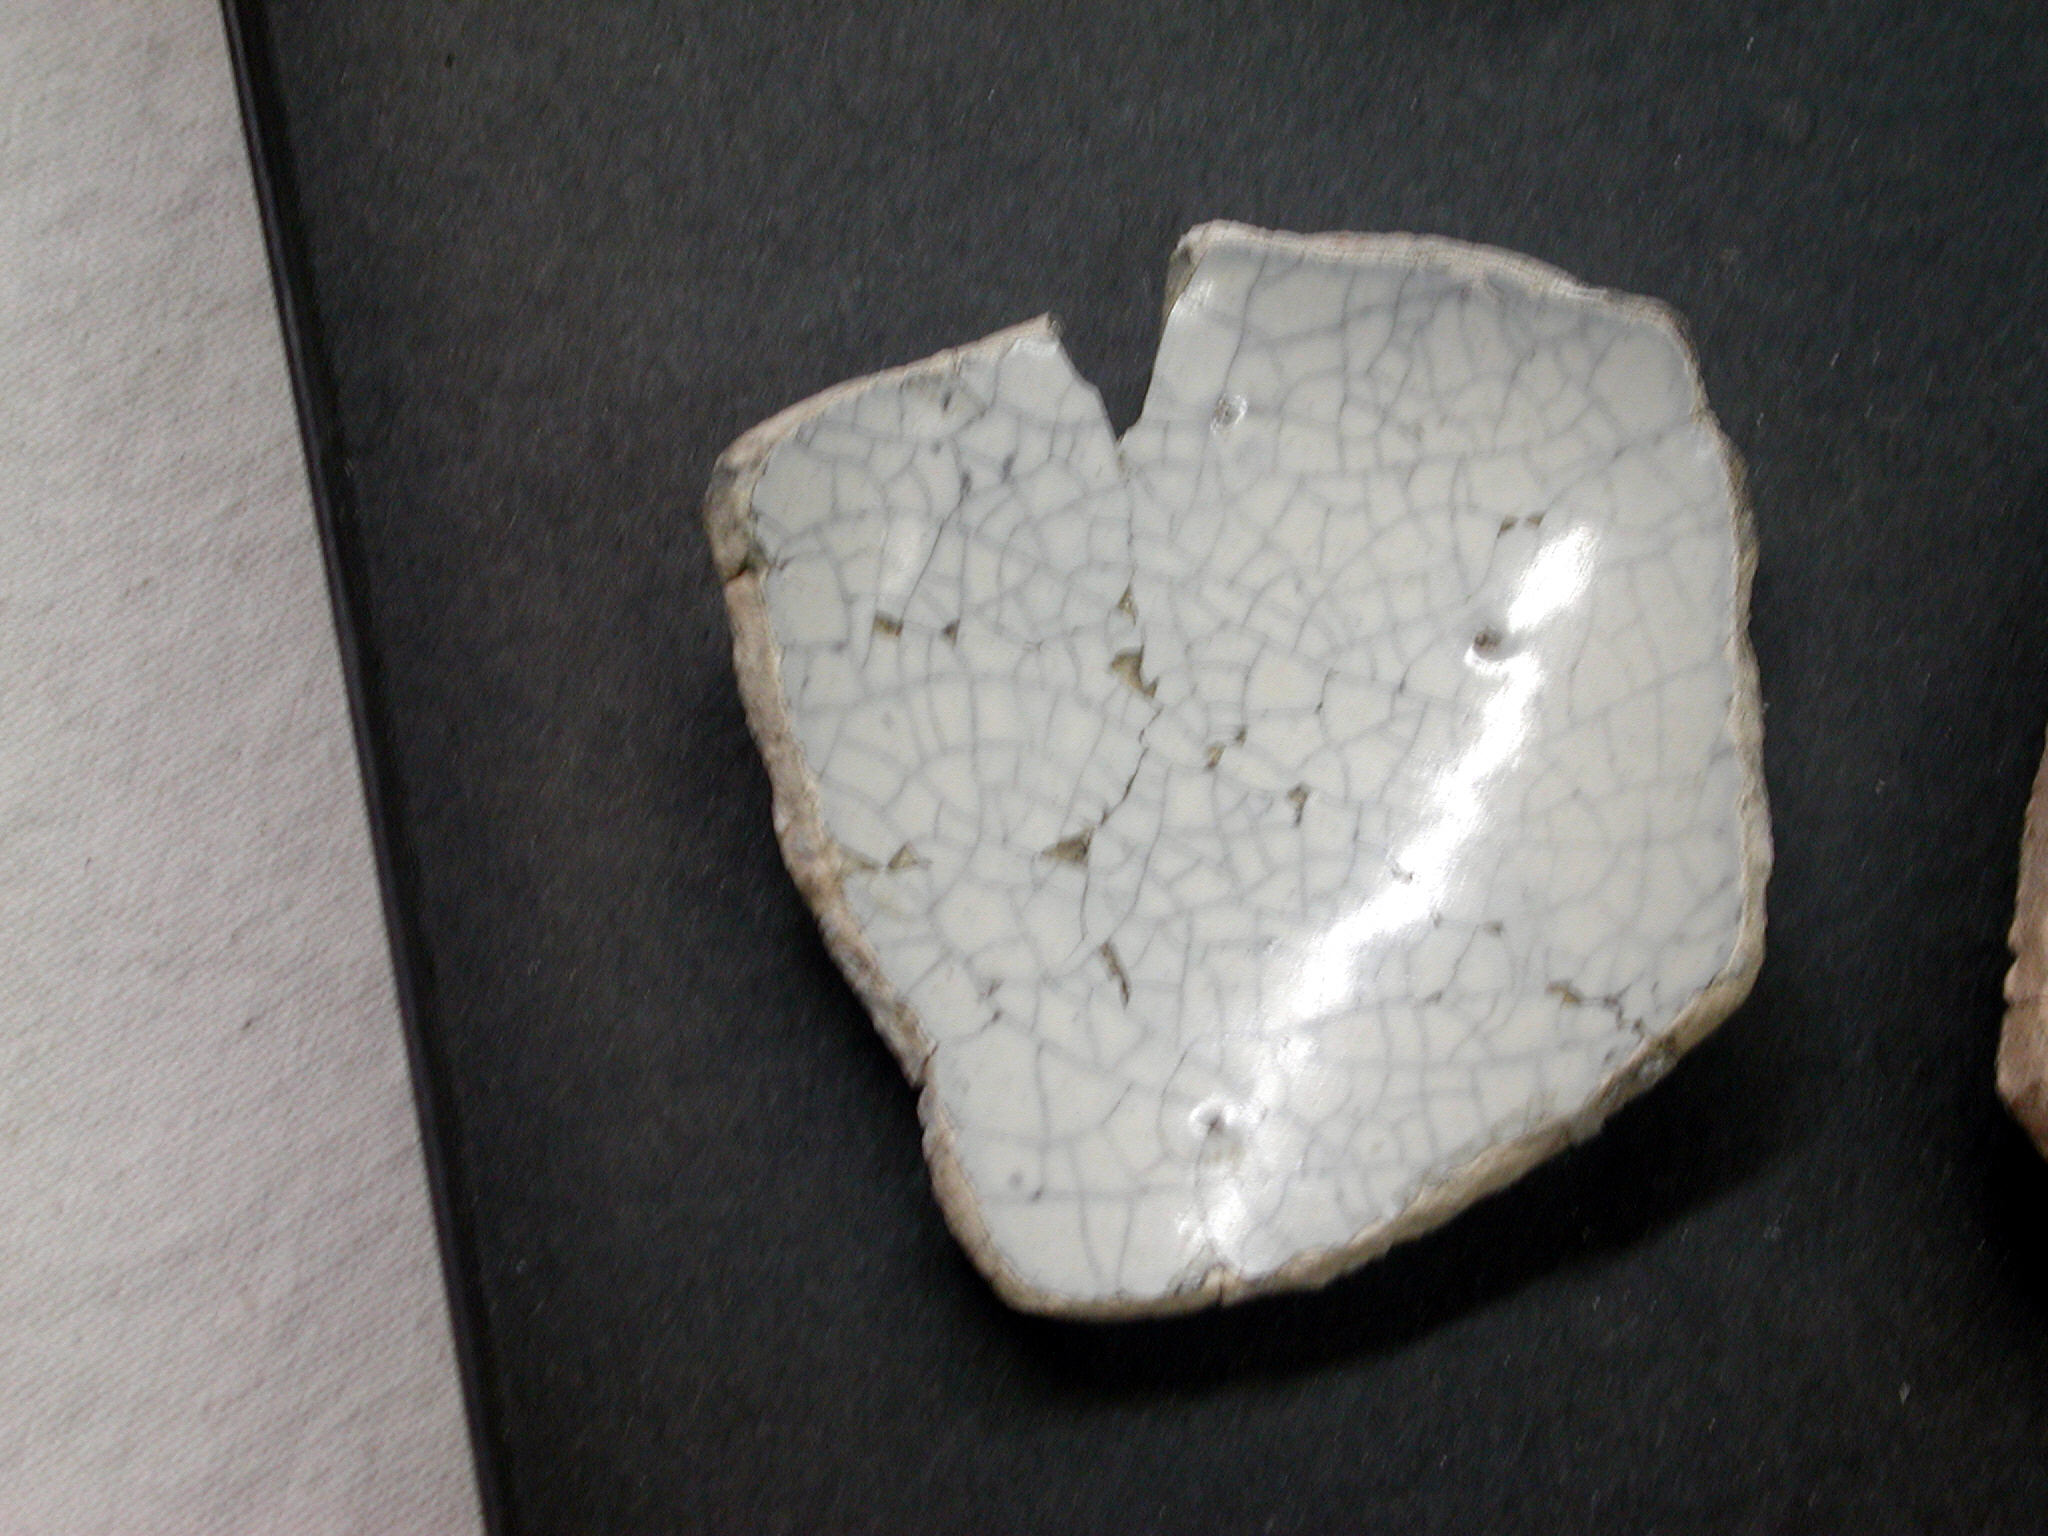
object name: fragment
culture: mexican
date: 1601-1650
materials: earthenware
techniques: glazing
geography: mexico